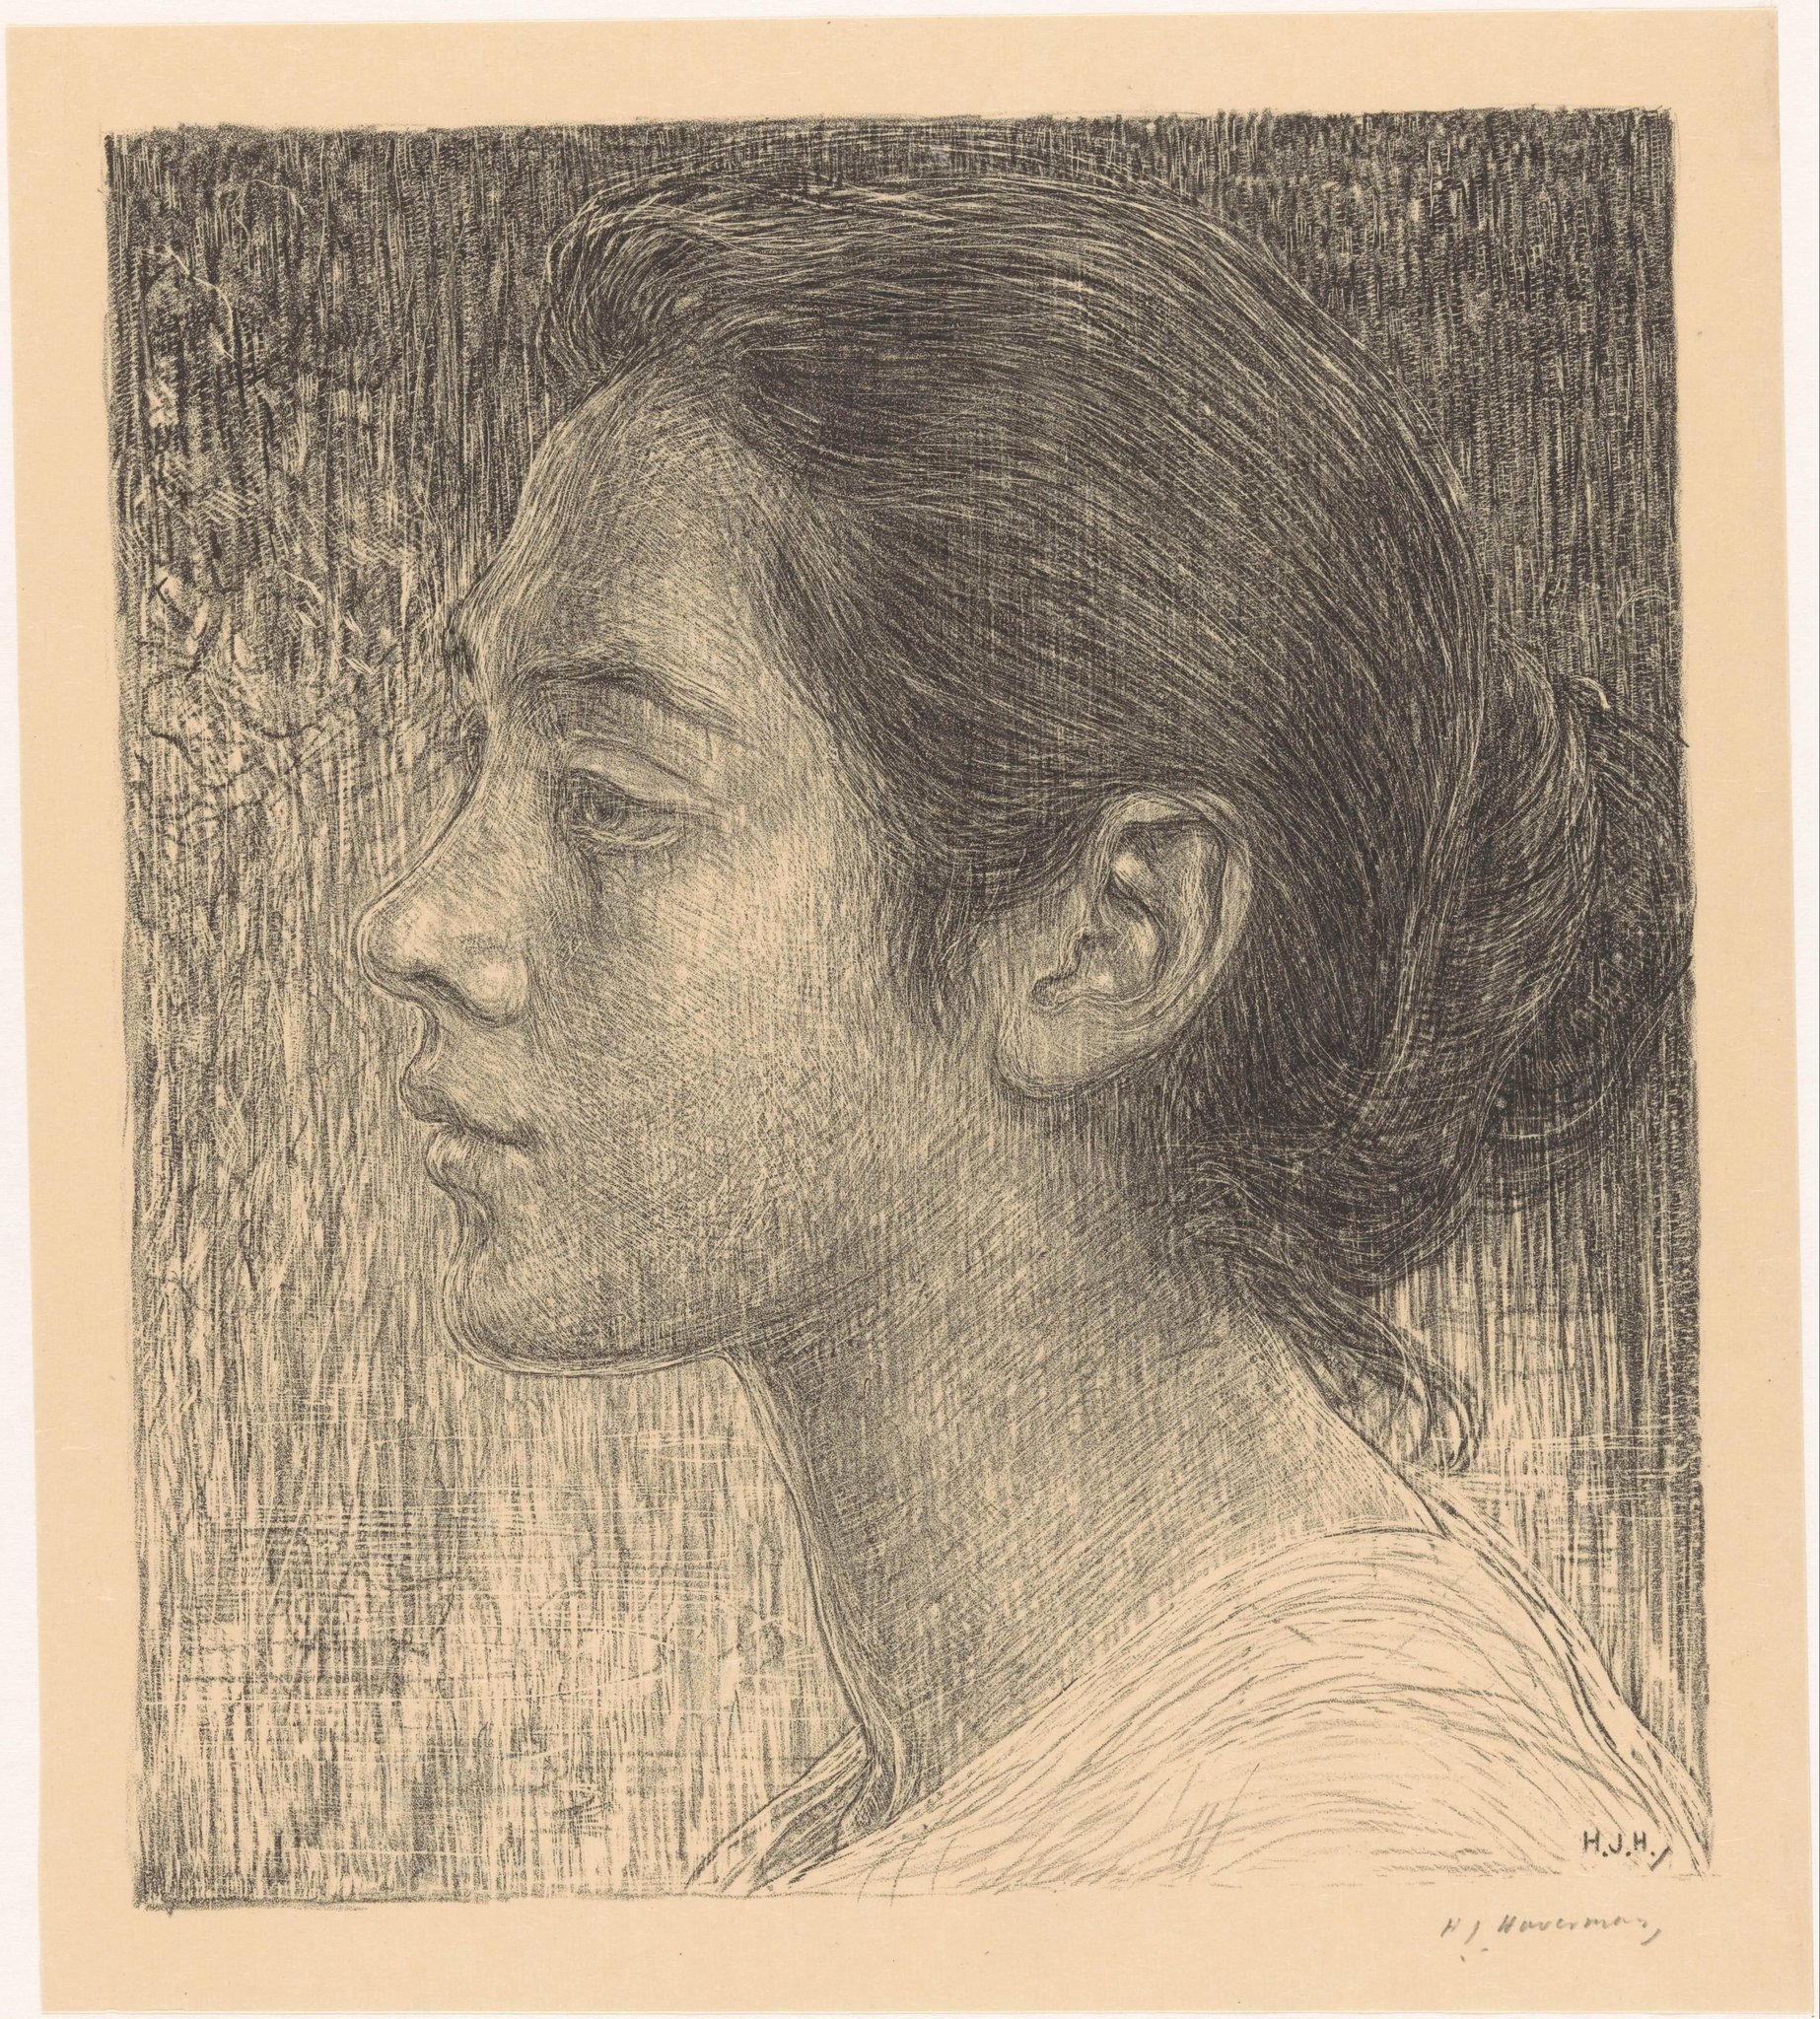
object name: print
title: Portret van een onbekende vrouw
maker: hendrik johannes haverman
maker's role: draughtsman, print maker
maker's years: 1857-1928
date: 1867-1928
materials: paper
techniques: lithograph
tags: anonymous historical person portrayed - bb - woman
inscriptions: collector's mark: Lugt 2228